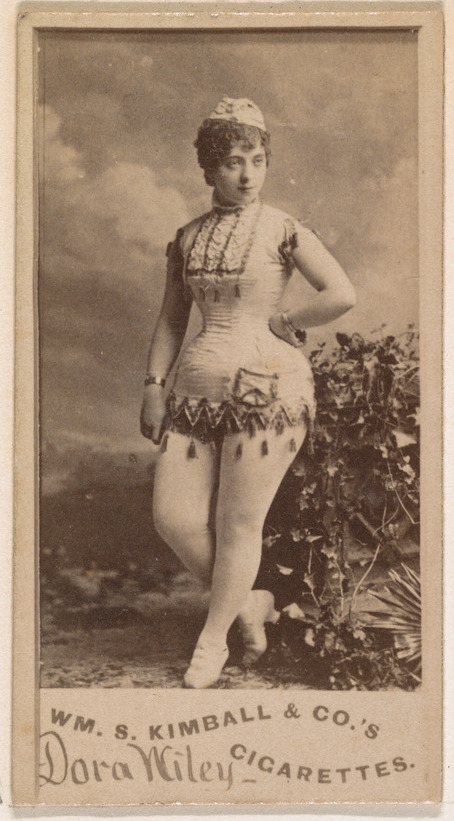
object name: photograph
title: Dora Wiley, from the Actresses series (N203) issued by Wm. S. Kimball & Co.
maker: william s. kimball & company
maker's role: publisher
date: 1889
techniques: color lithograph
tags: portraits,women,actresses